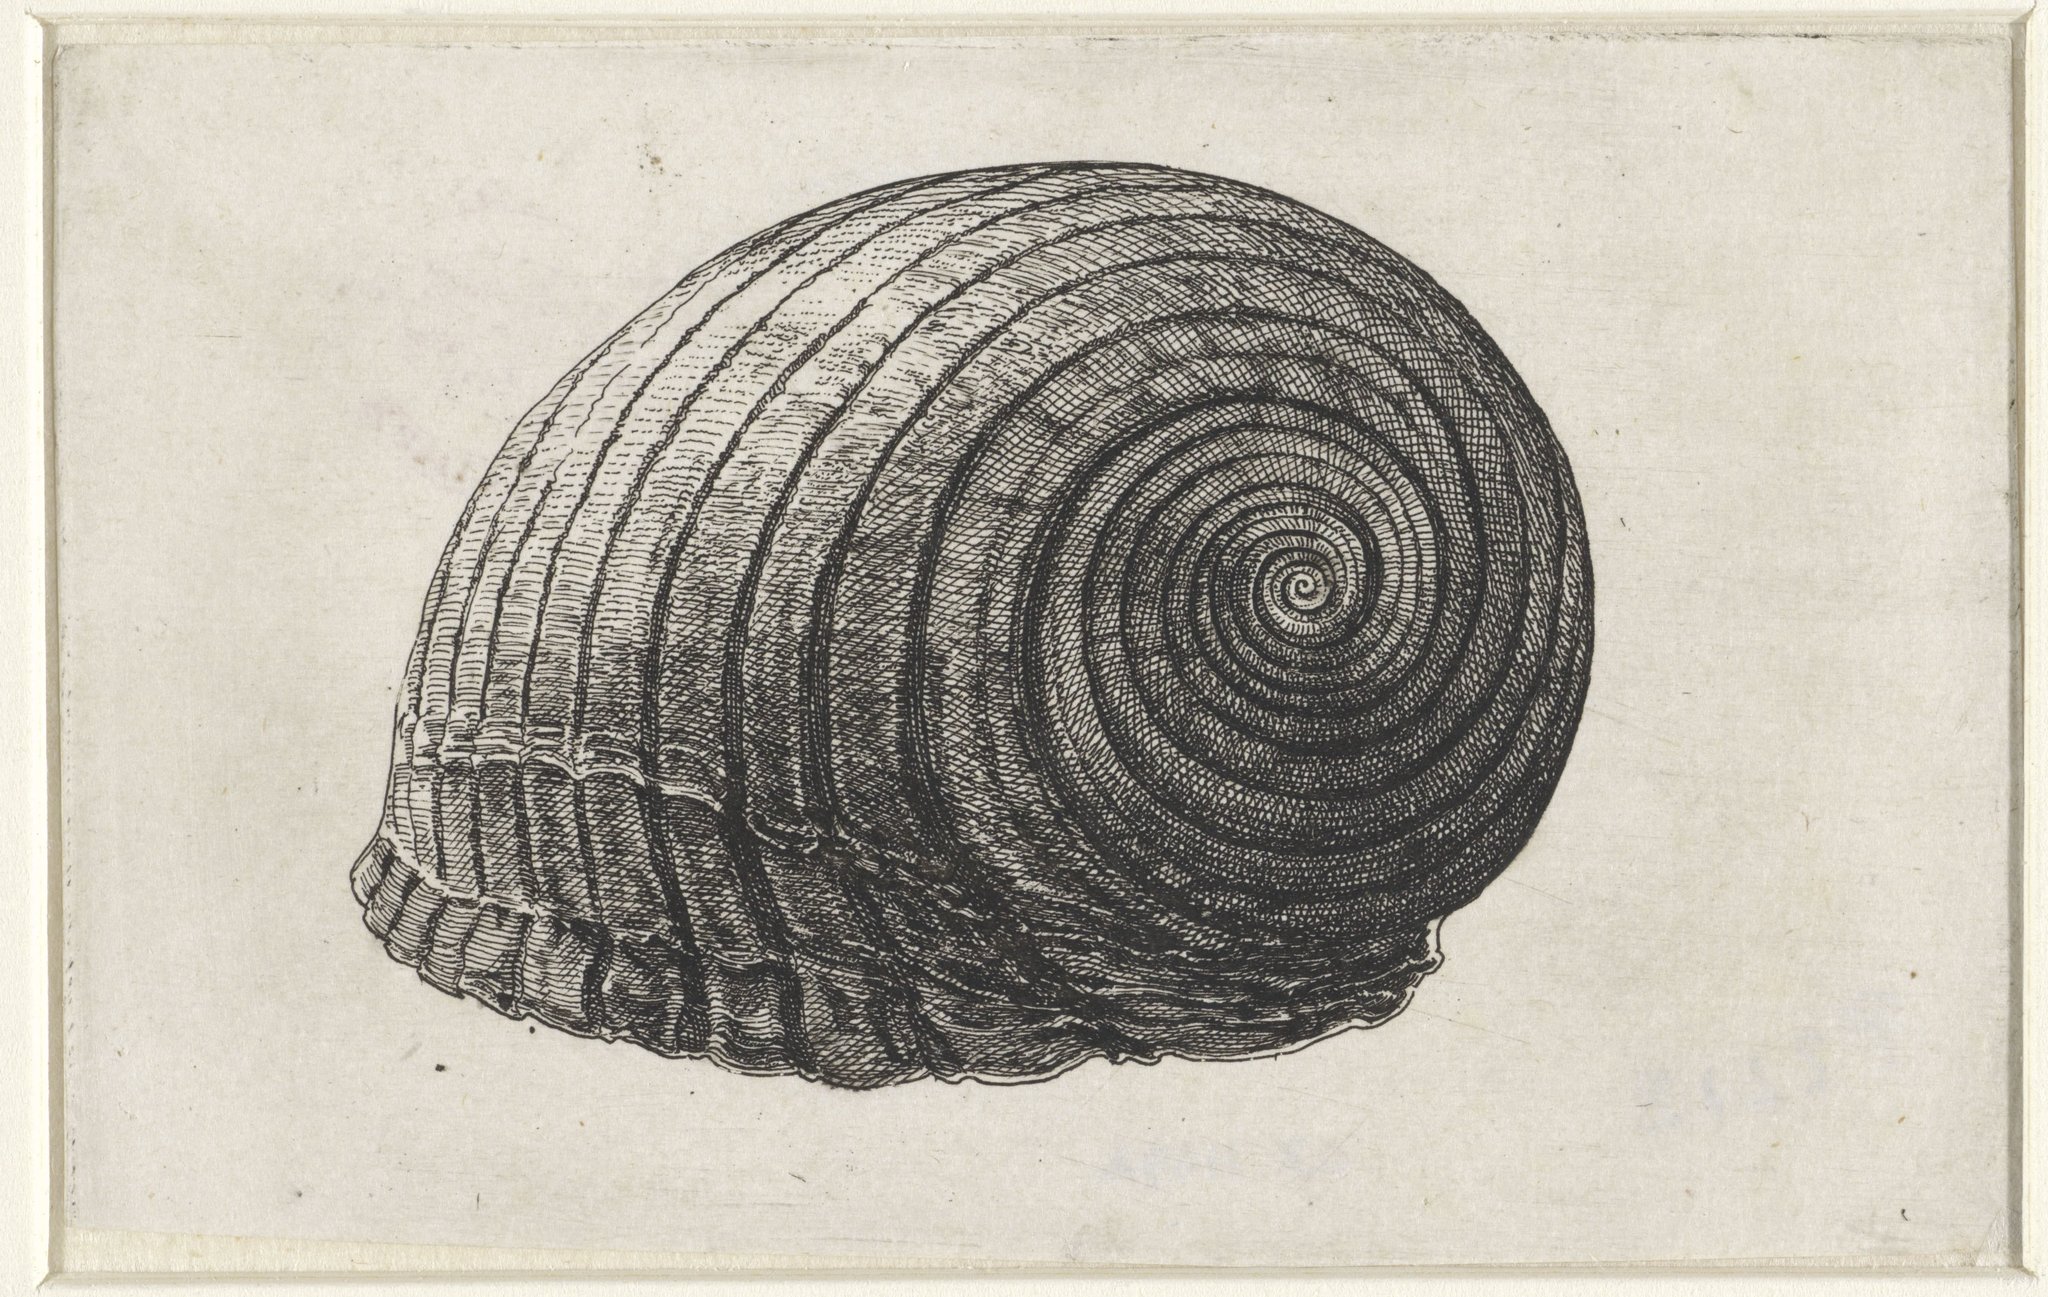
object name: print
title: Schelp, tonna galea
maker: wenceslaus hollar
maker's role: draughtsman, print maker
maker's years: 1607-1677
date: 1644-1652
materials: paper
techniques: etching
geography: antwerp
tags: molluscs (+ shell, snail-shell etc.)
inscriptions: collector's mark: Lugt 240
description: Prent maakt deel uit van een 39-delige serie met verschillende soorten schelpen.